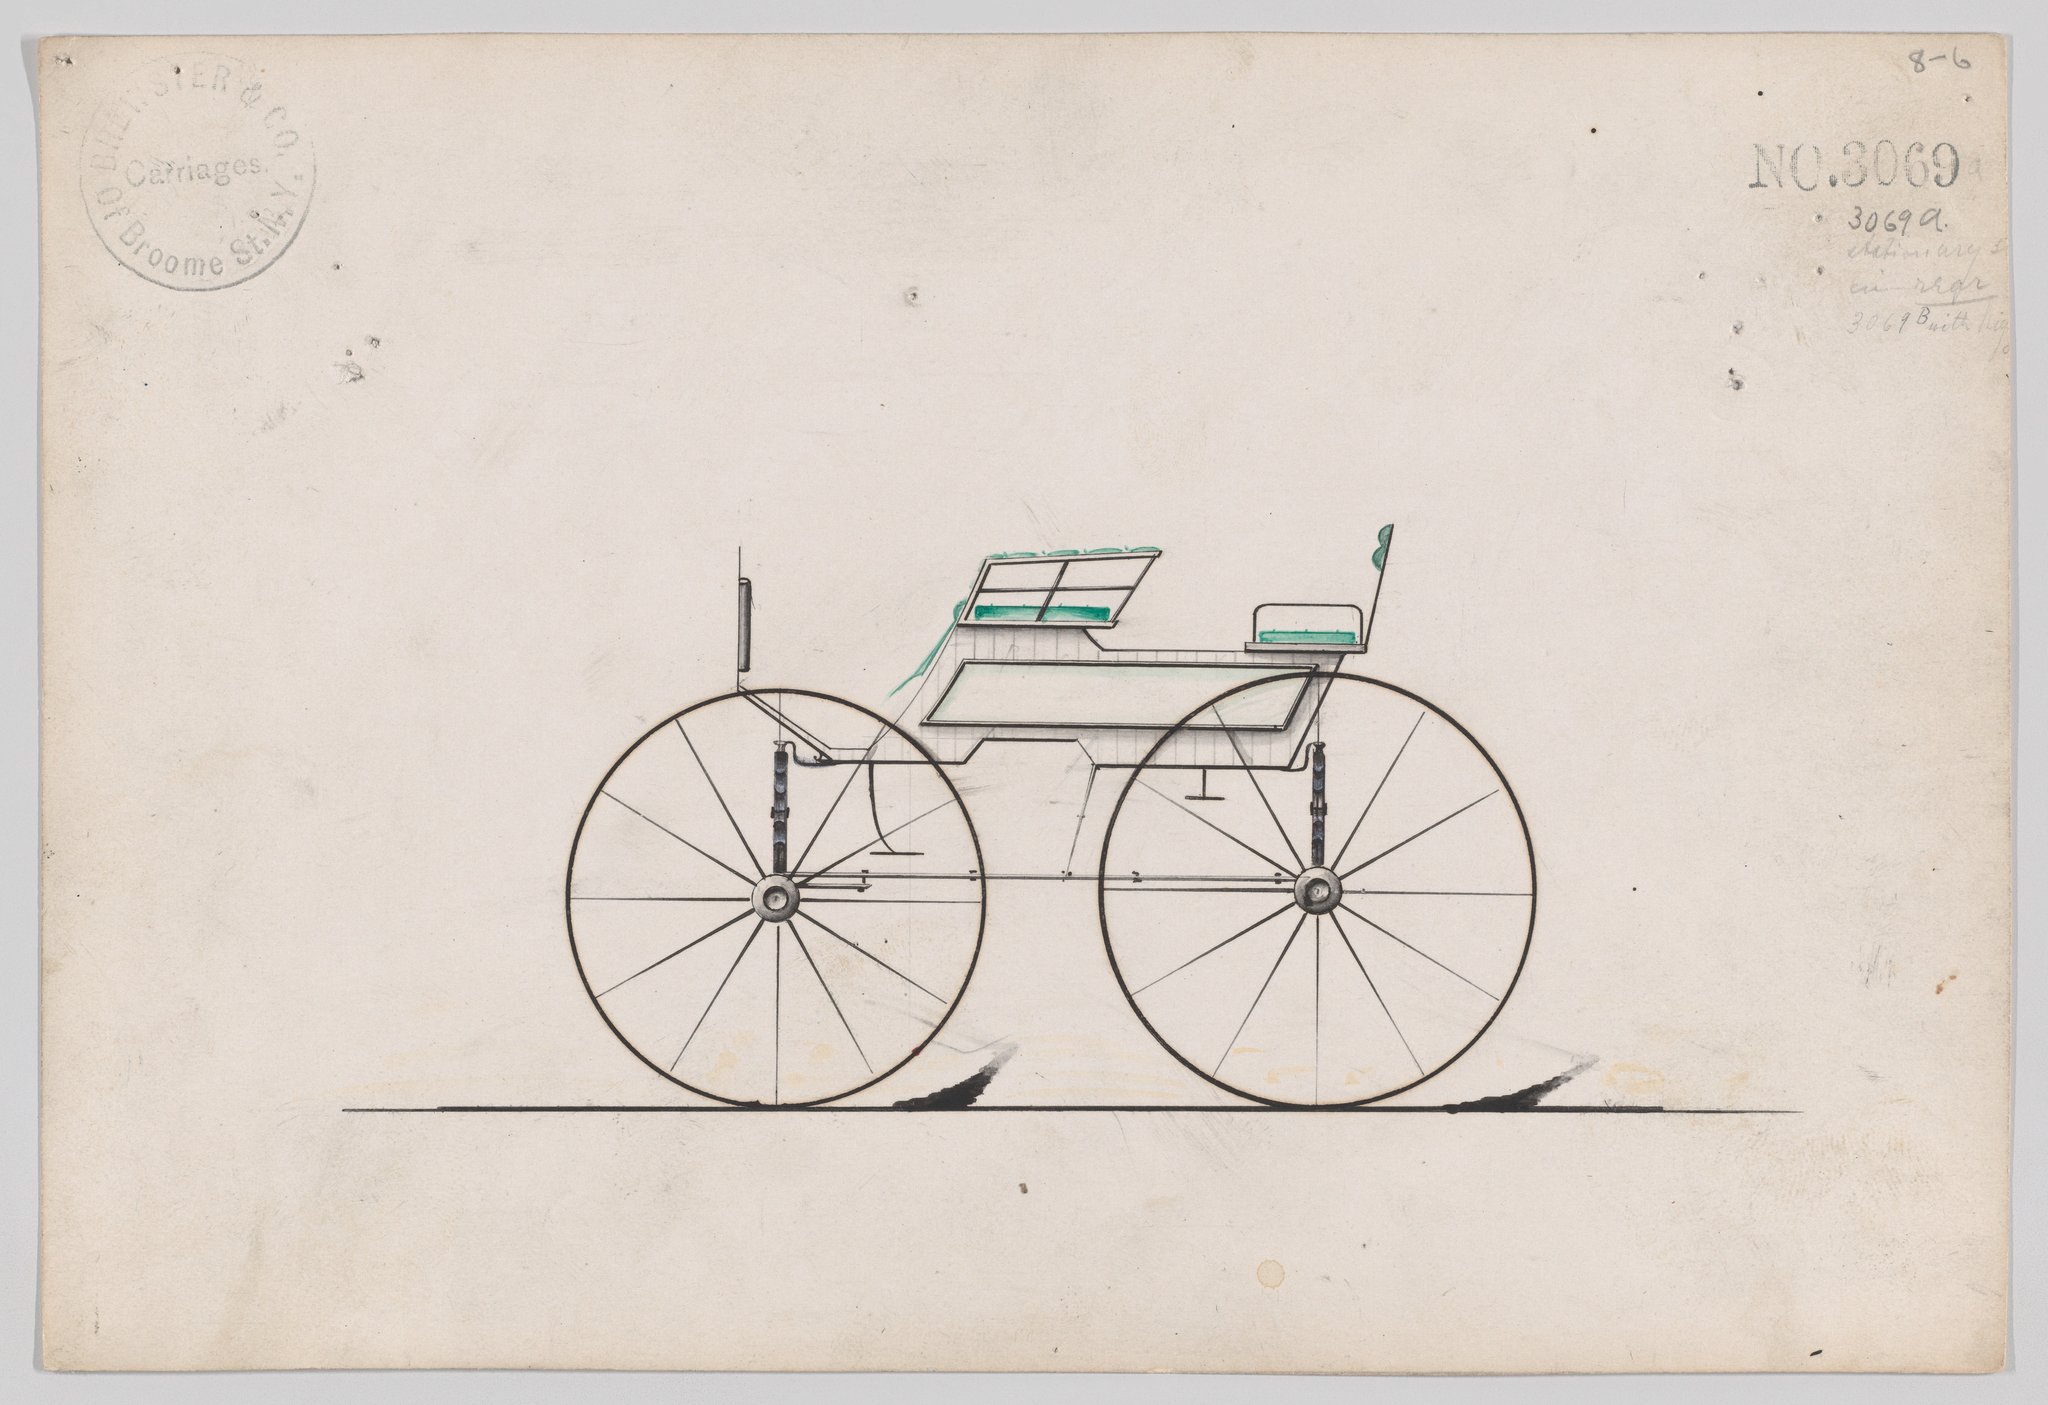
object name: drawing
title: Design for 4 seat Phaeton, no top, no. 3069a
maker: brewster & co.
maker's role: manufacturer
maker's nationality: american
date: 1874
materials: gouache, ink, watercolor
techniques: pen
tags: carriages